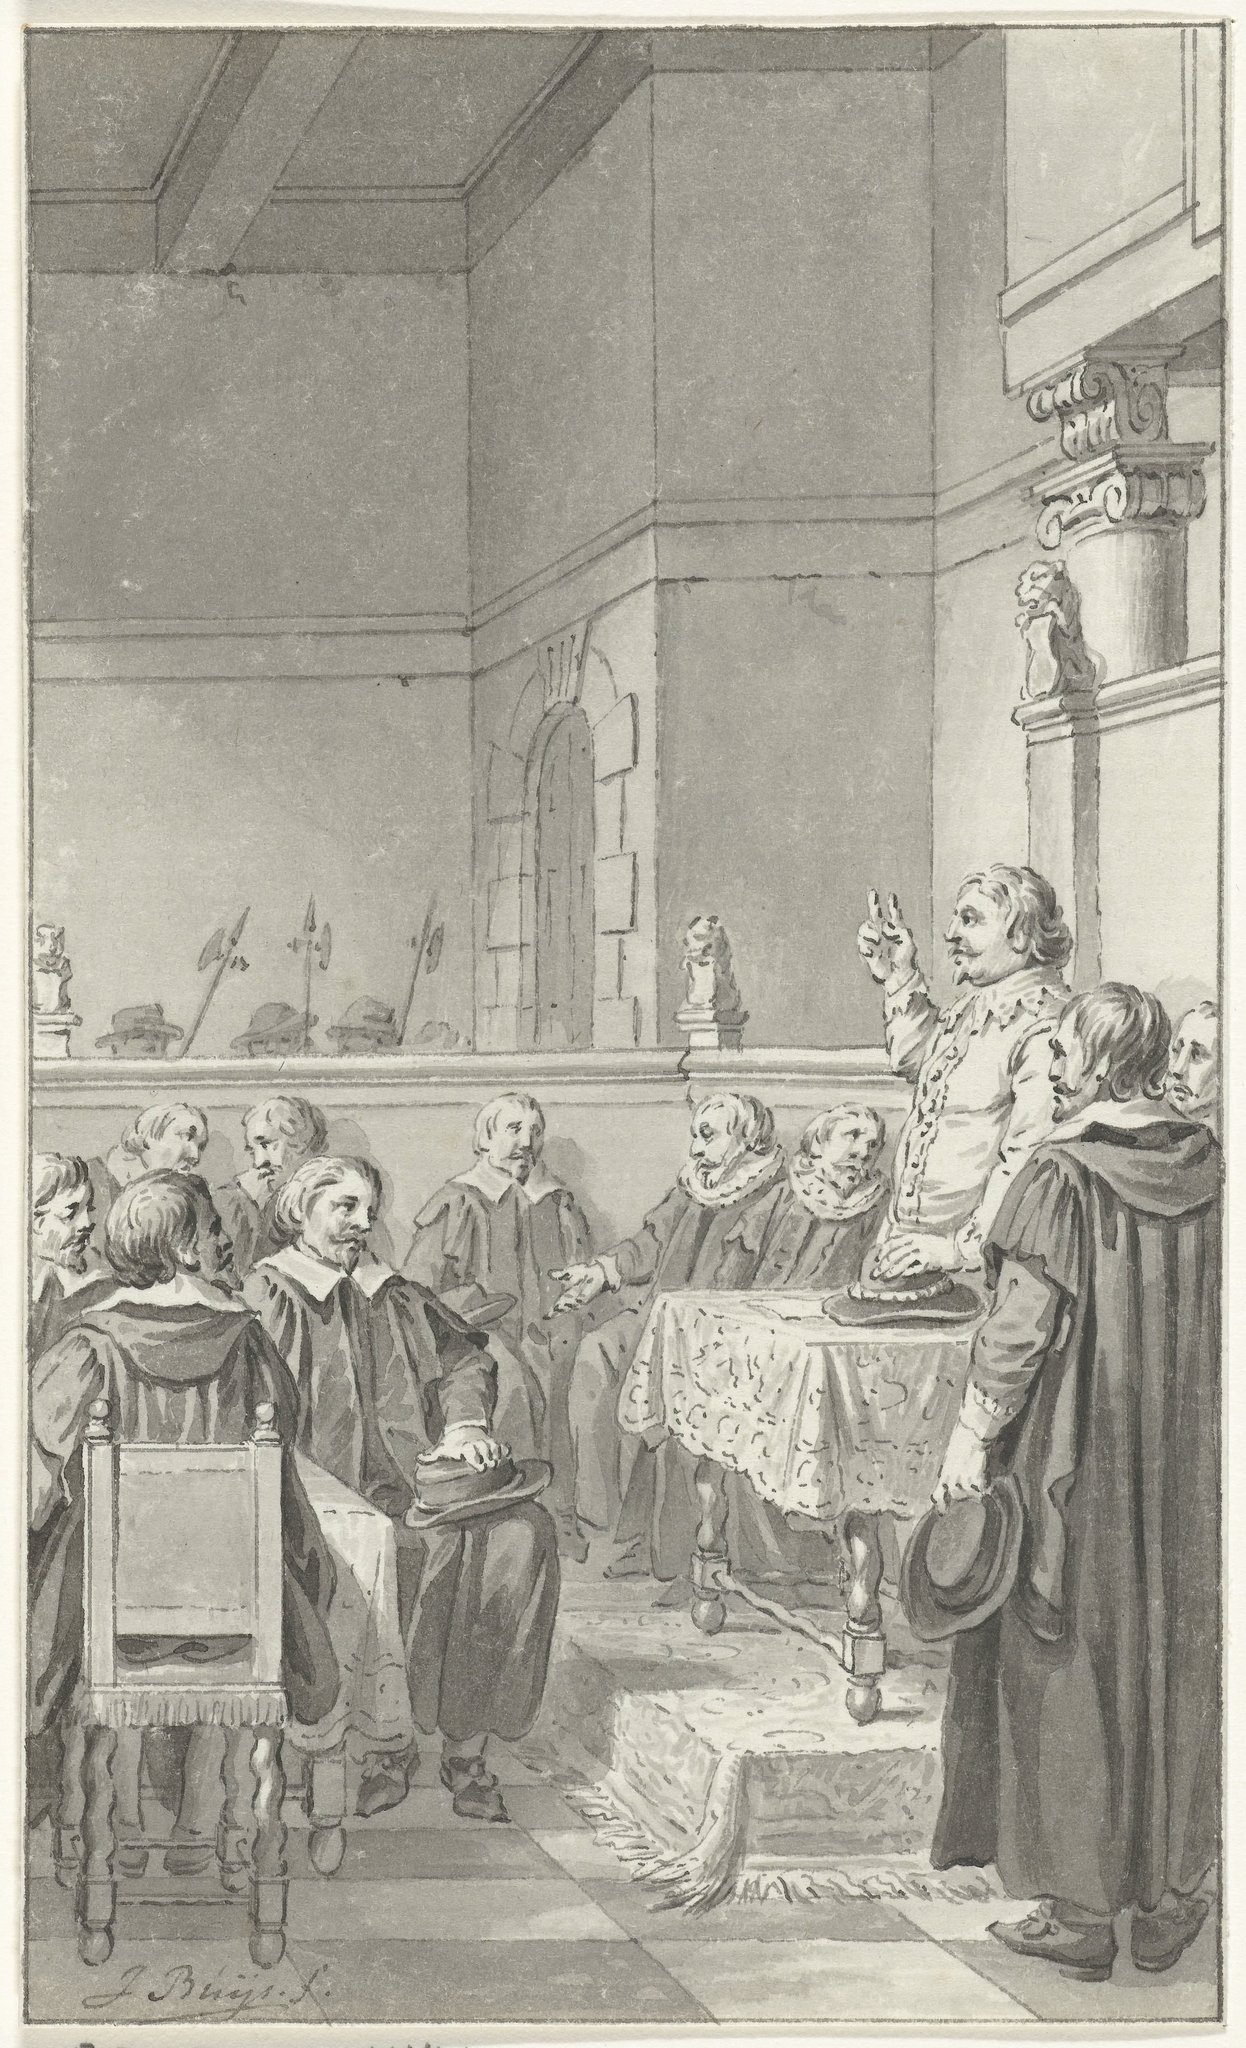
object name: drawing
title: Frederik Hendrik legt de eed af als stadhouder, 1625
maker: jacobus buys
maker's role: draughtsman, print maker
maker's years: 1724-1801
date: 1786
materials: ink, paper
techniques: brush, pen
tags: delft, the hague, frederick henry (prince of orange), new ruler taking the oath, historical persons, names of organizations, companies, trade unions, etc., witnesses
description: Ontwerptekening voor illustratie in: Jacobus Kok, Vaderlandsch Woordenboek, Johannes Allart, Amsterdam 1785-1799, 35 delen, dl. XVI, pl. I.